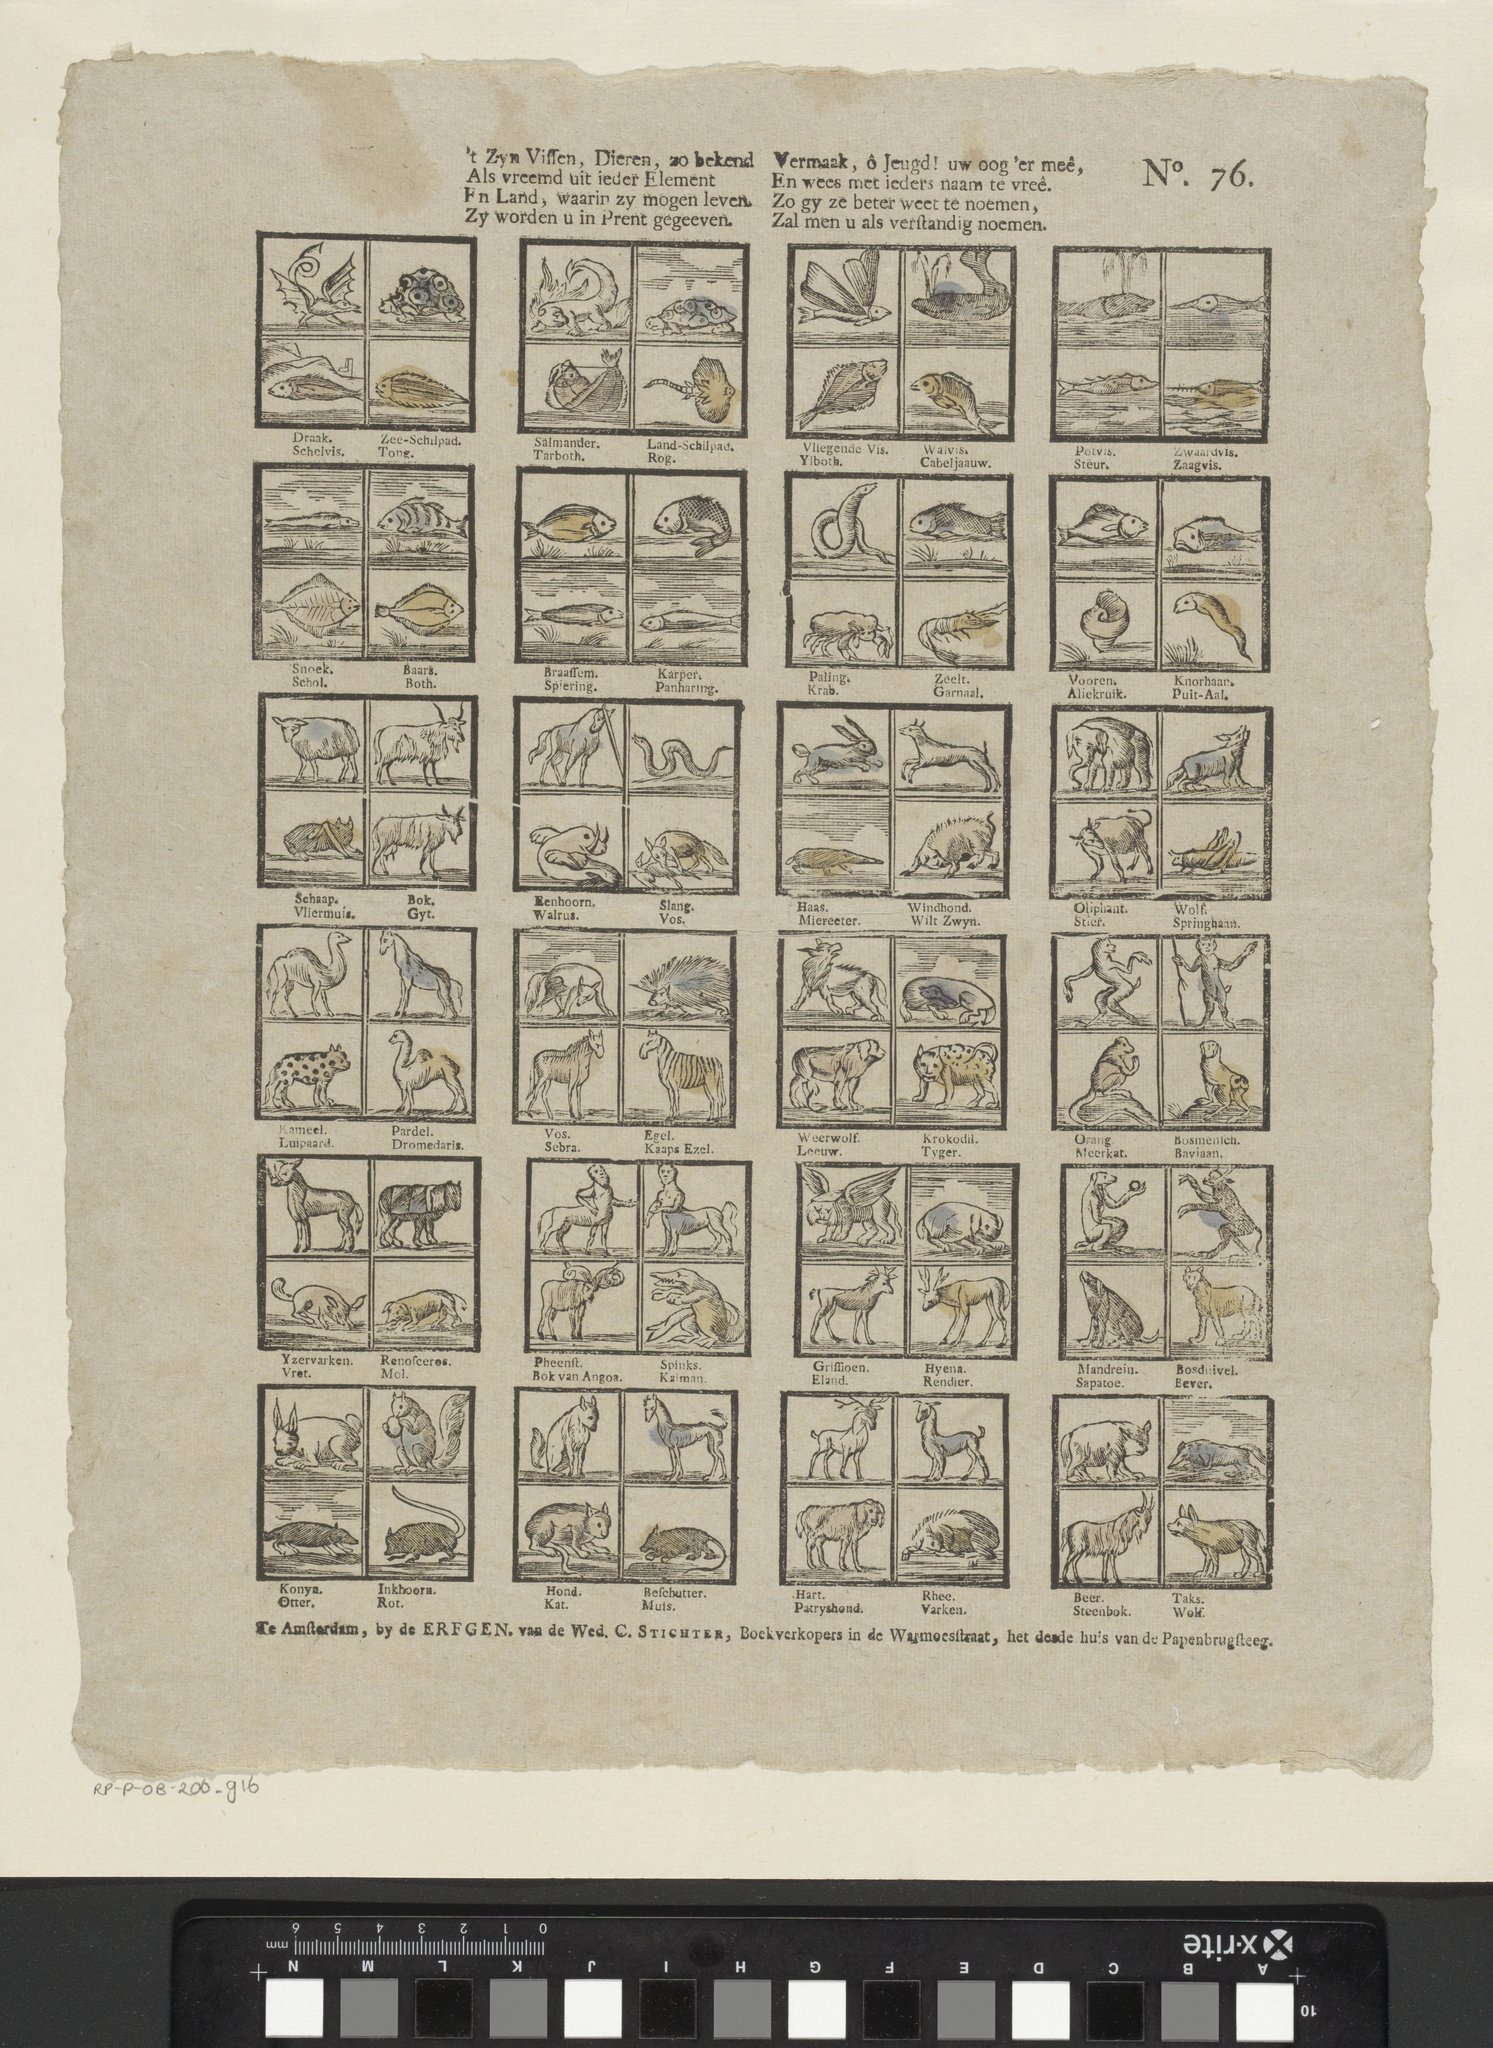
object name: popular print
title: 'T zyn vissen, dieren, zo bekend / Als vreemd uit ieder element [(...)]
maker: Anonymous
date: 1715-1813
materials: paper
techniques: colour, letterpress printing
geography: netherlands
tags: animals, fishes, rodents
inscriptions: collector's mark: Lugt 2760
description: Blad met 24 voorstellingen met elk vier dieren, zoals een vissen, een schildpad, een haas en een tijger. Onder elke voorstelling de namen van de dieren. Genummerd rechtsboven: No. 76.